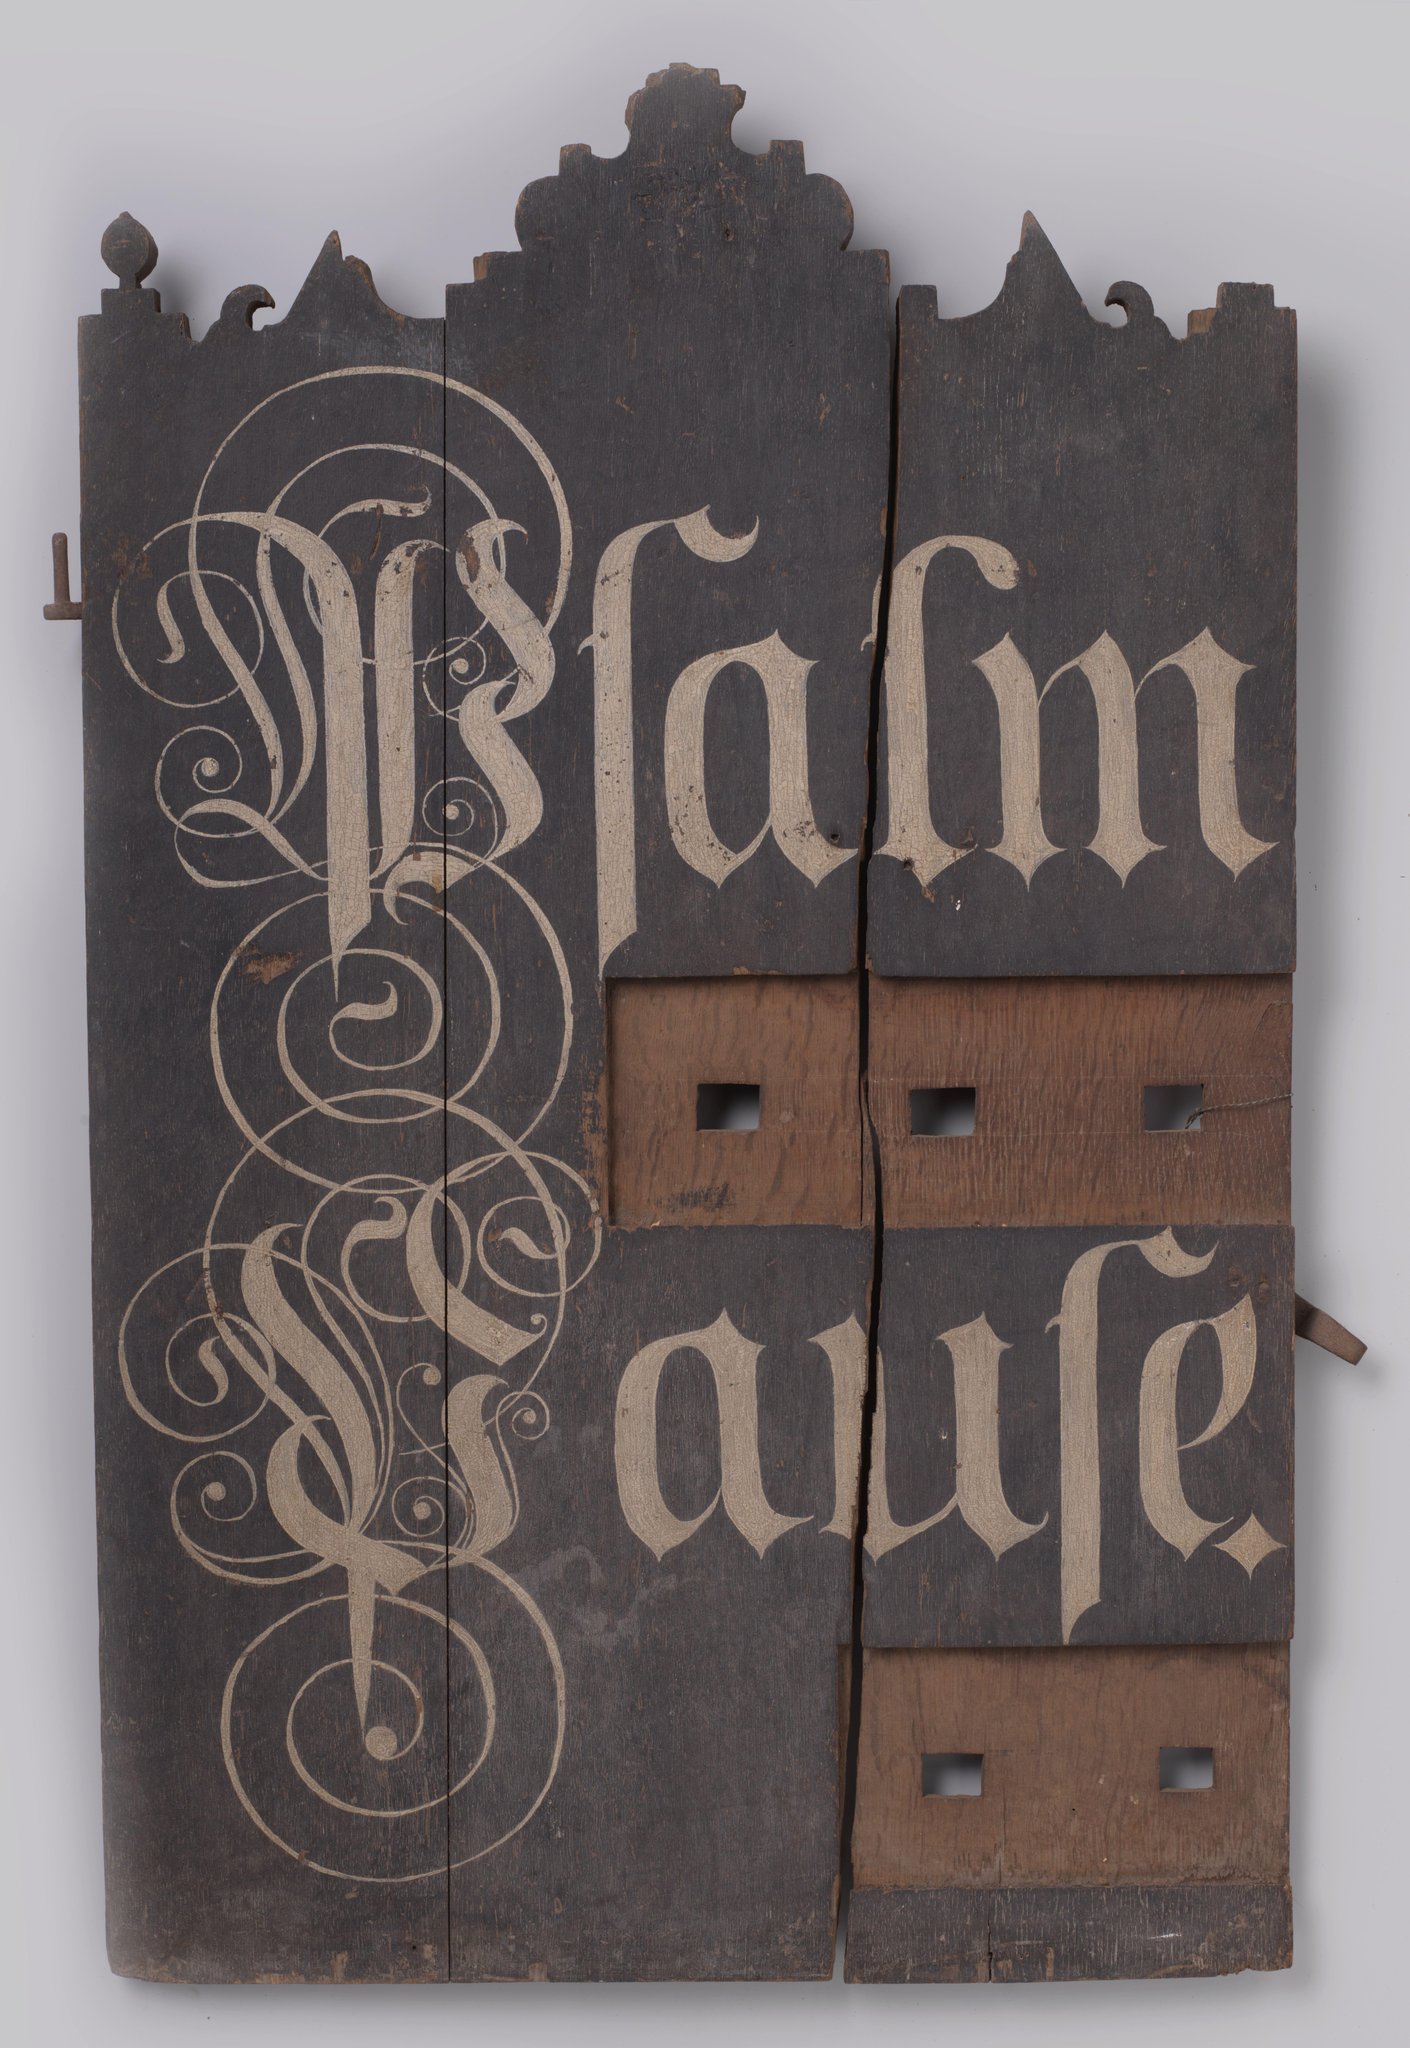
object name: hymn board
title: Gezangbord met tekst: "psalm en pauze"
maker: Anonymous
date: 1600-1699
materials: wood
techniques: painted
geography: netherlands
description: Gezangbord met de tekst: "psalm en pauze". Zie tevens: BK-NM-6056 en BK-NM-6058/6059.